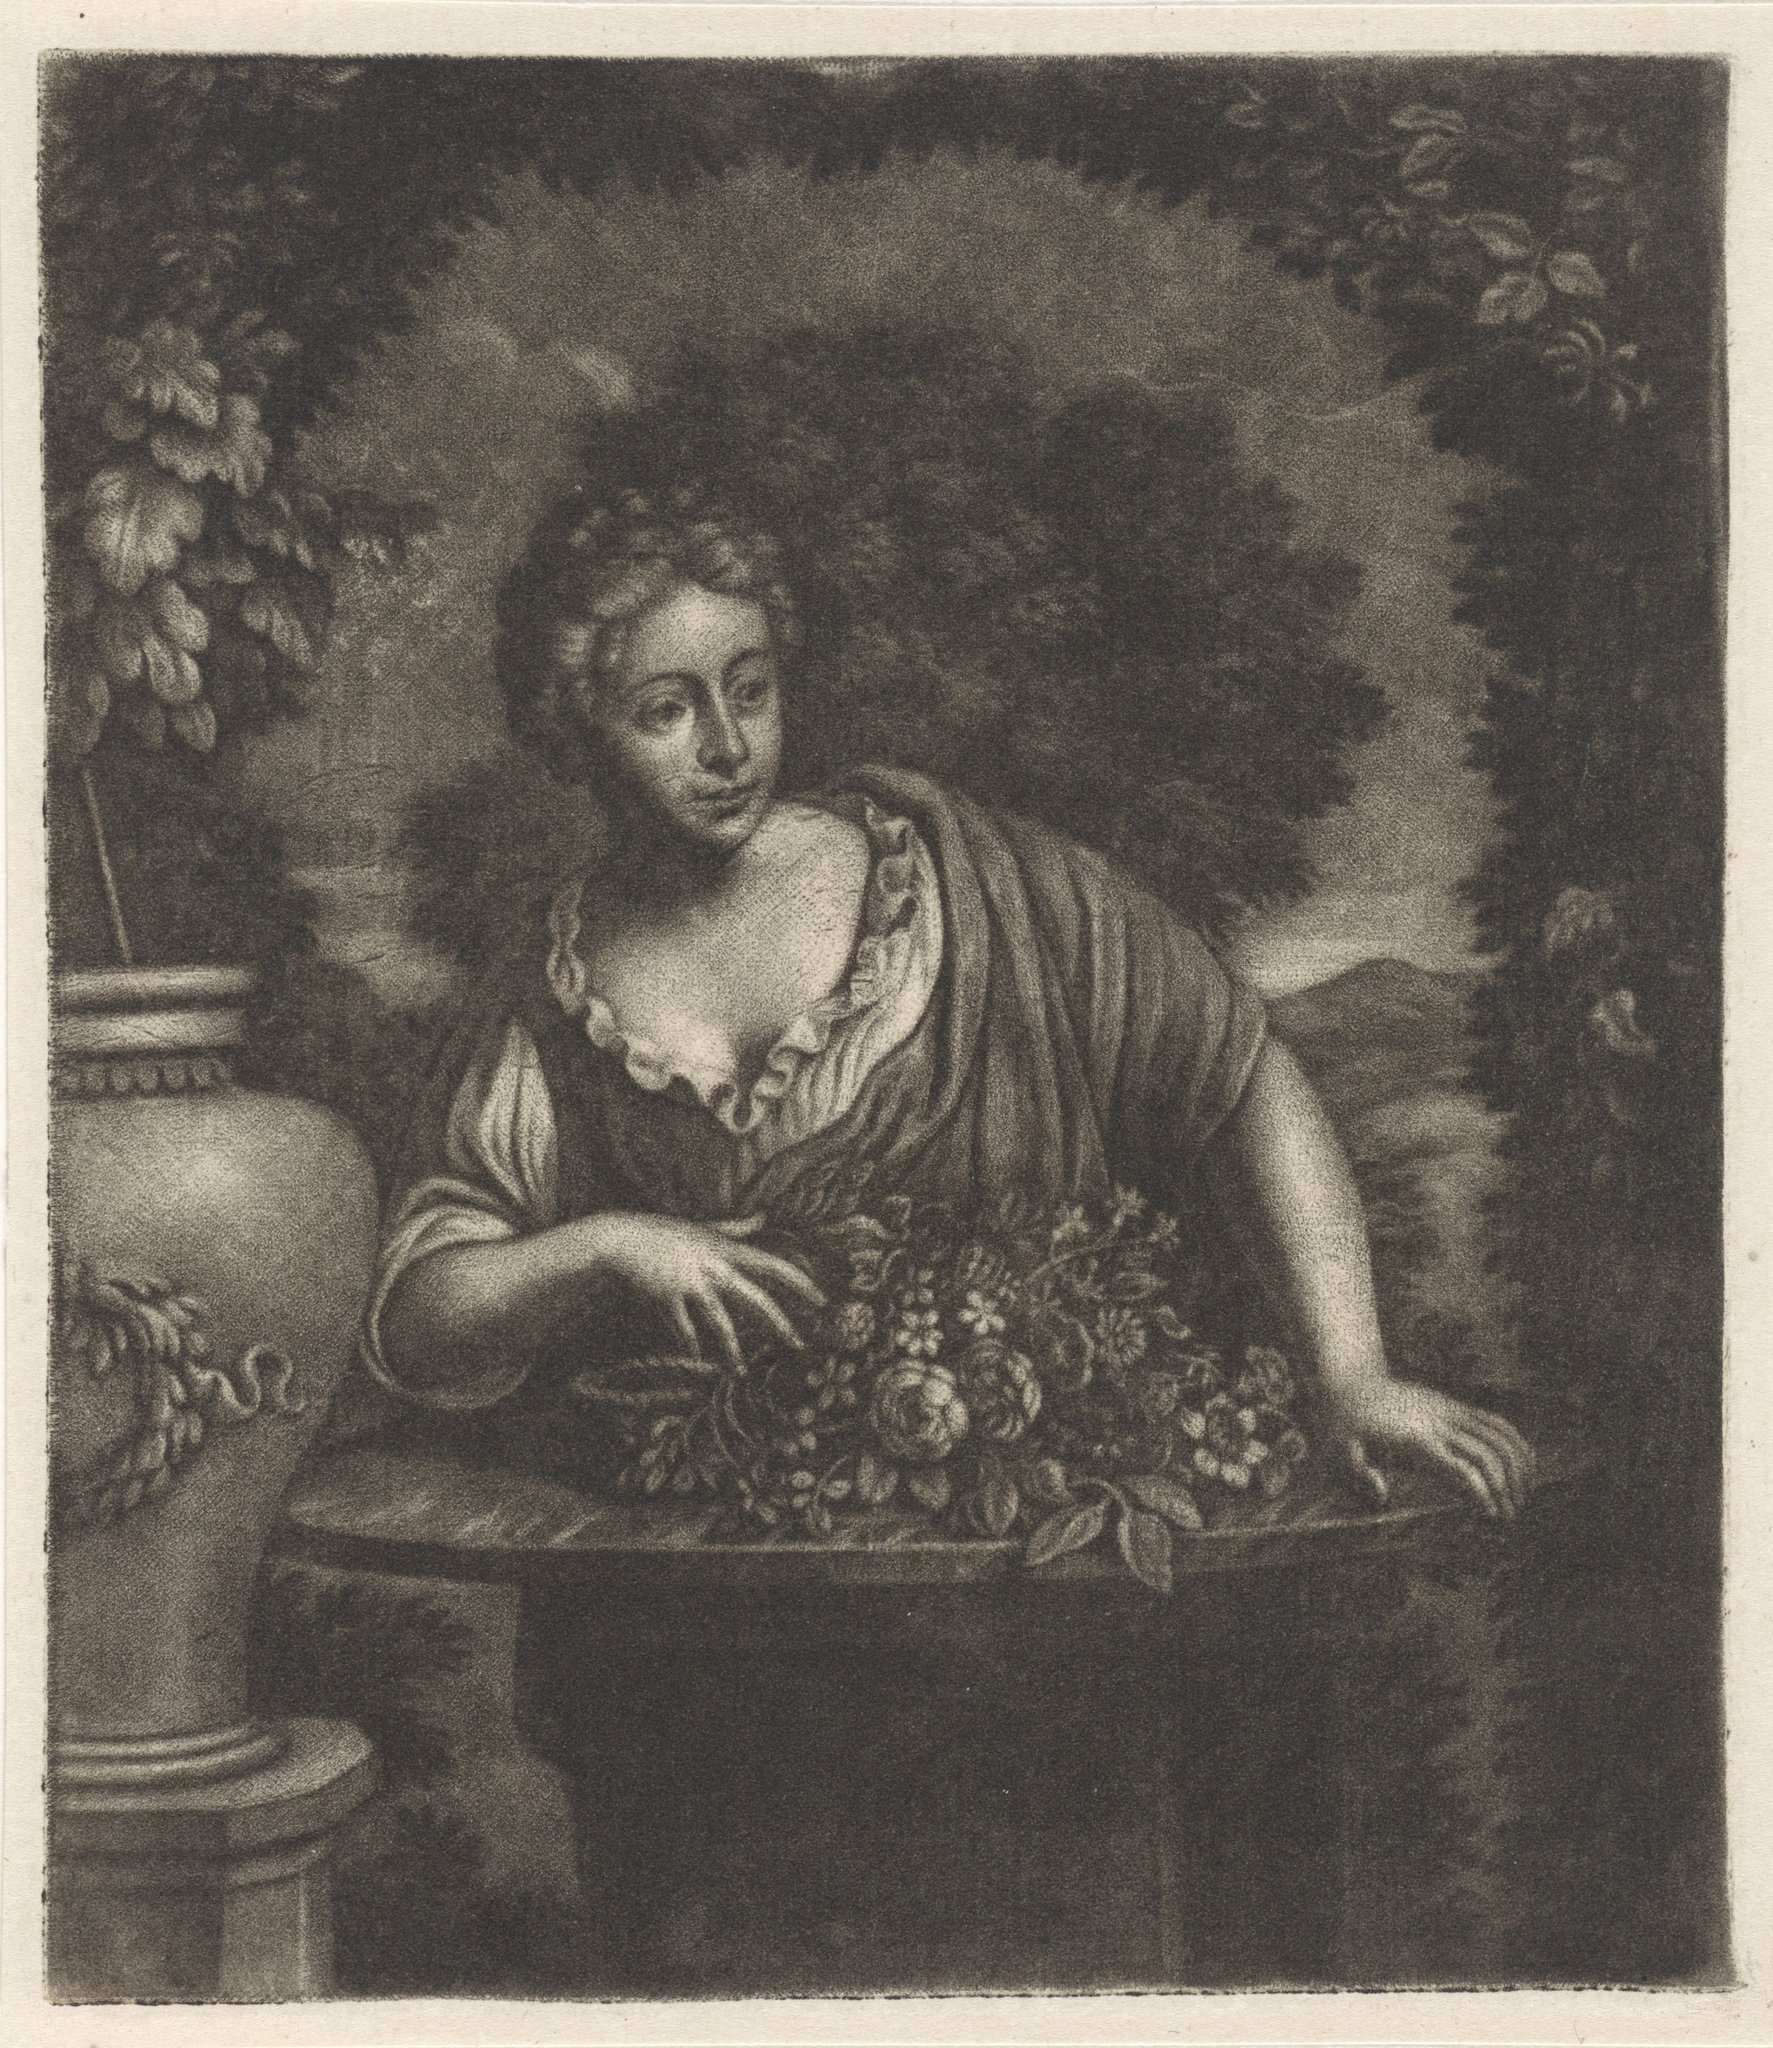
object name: print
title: Vrouw in een tuin achter een tafel met bloemen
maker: Anonymous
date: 1650-1800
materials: paper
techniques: mezzotint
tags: flowers, garden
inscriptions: collector's mark: Lugt 2228